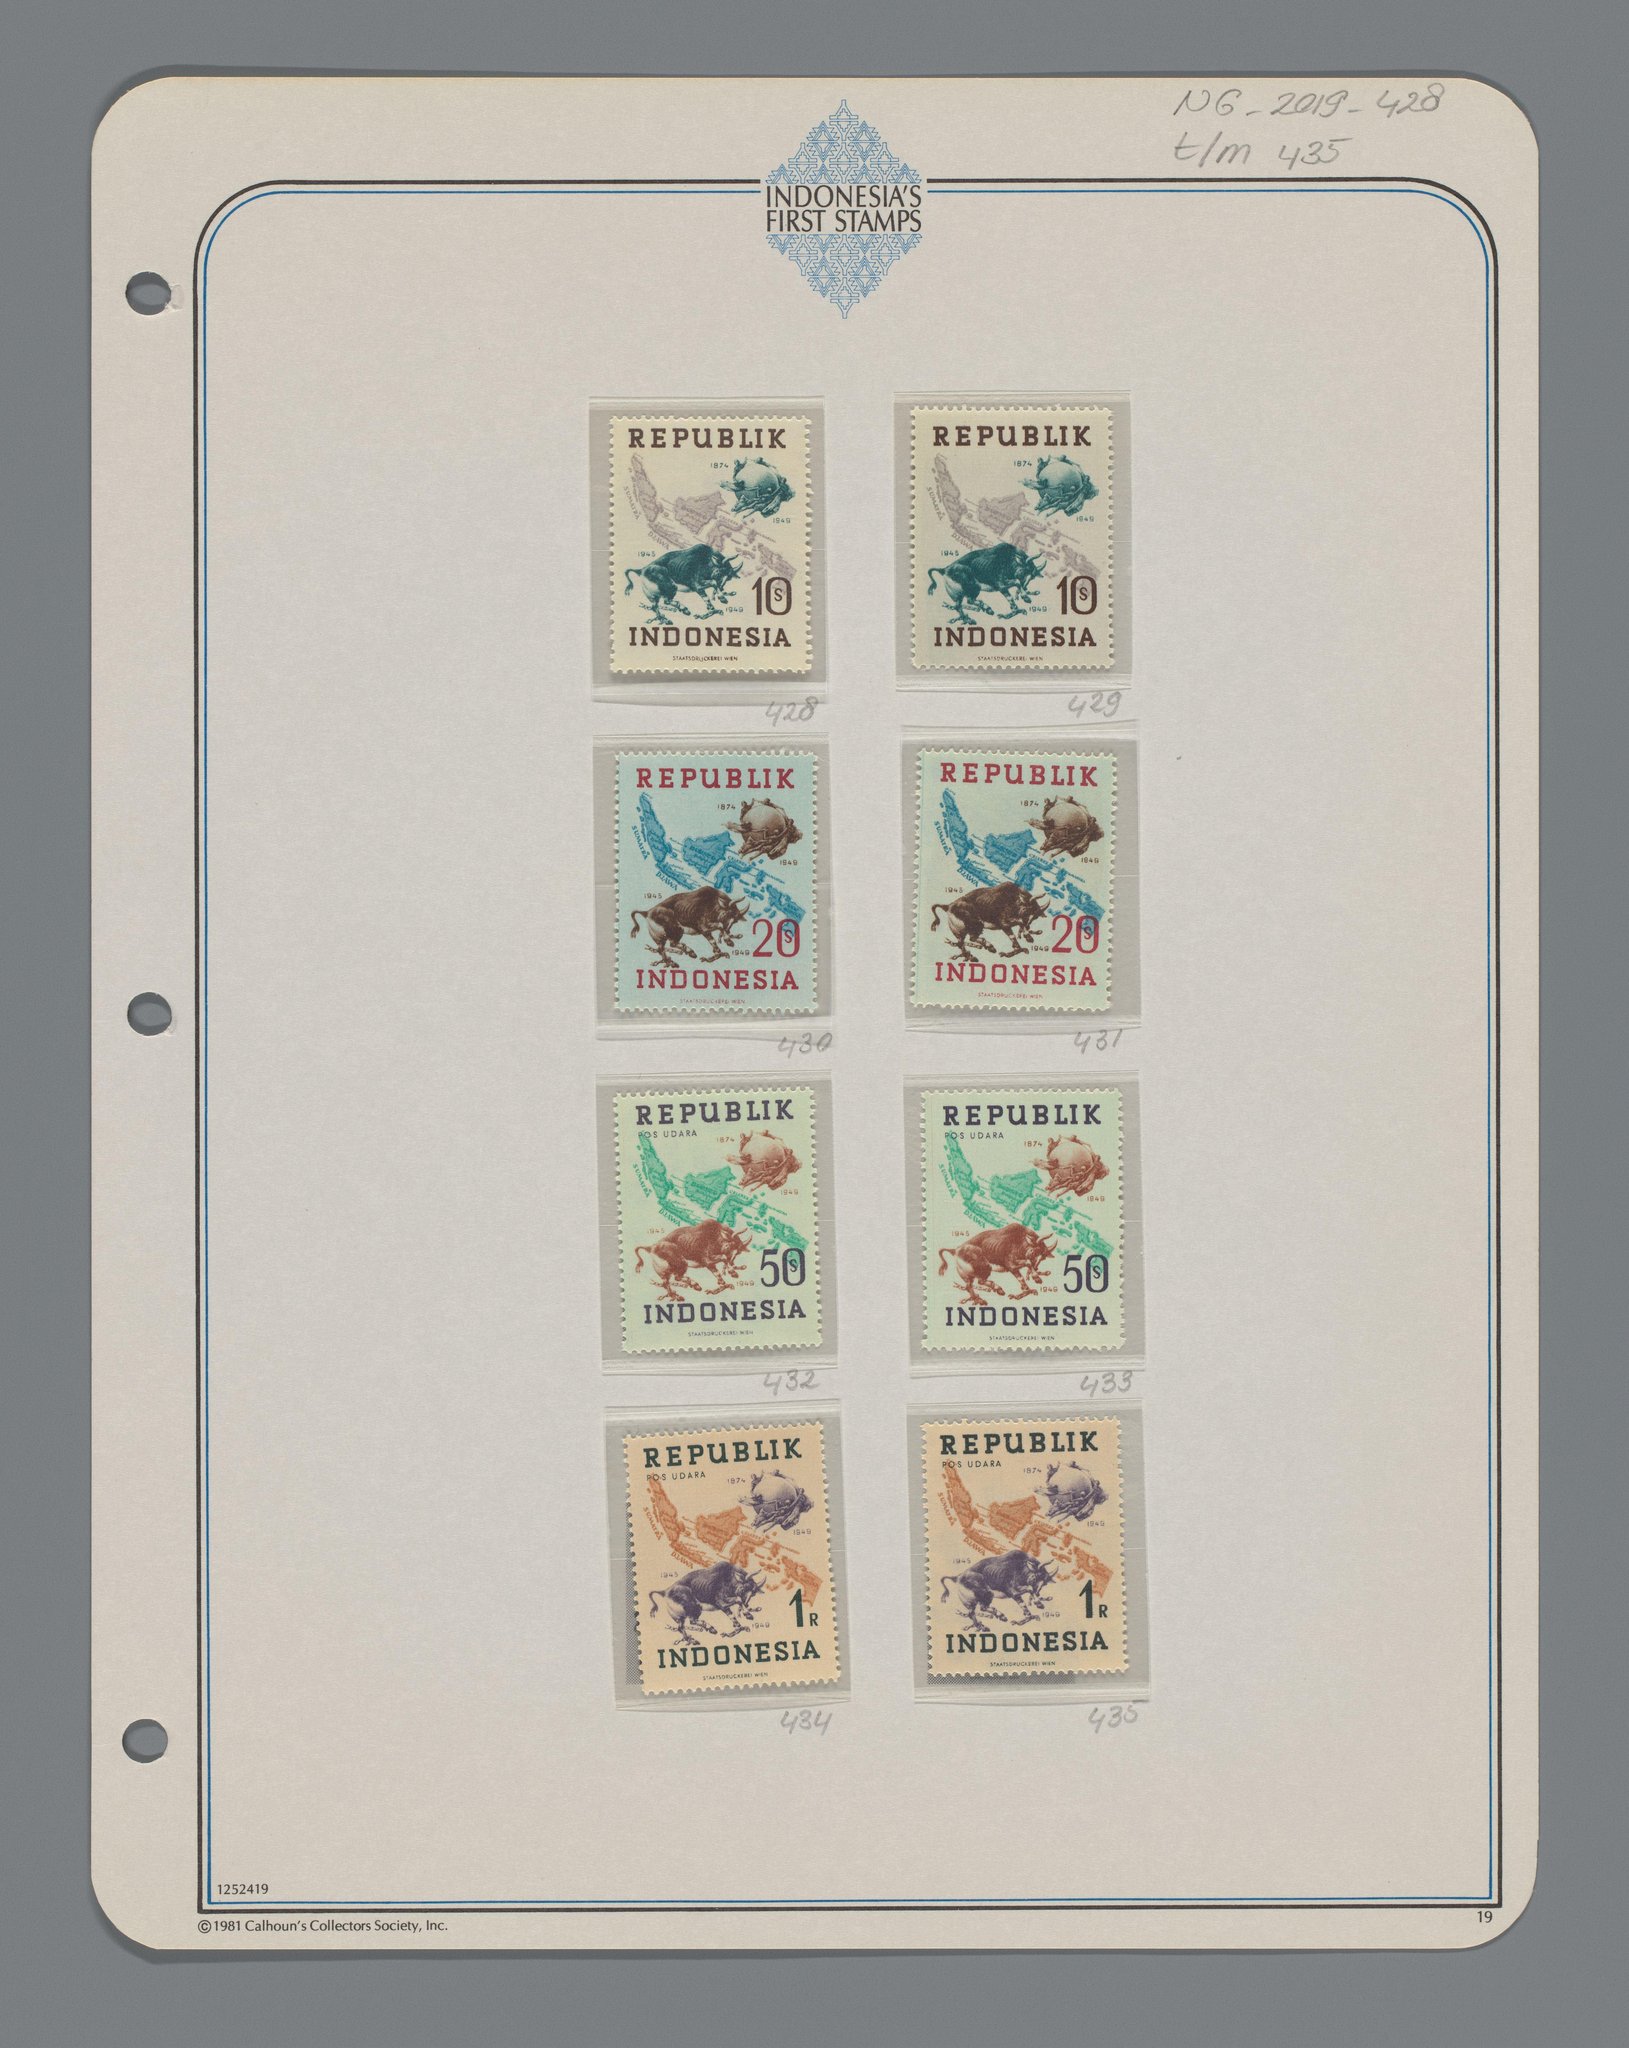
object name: postage stamp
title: Postzegel Republik Indonesia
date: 1949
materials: paper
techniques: photoaquatint, engraving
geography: philadelphia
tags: indonesia